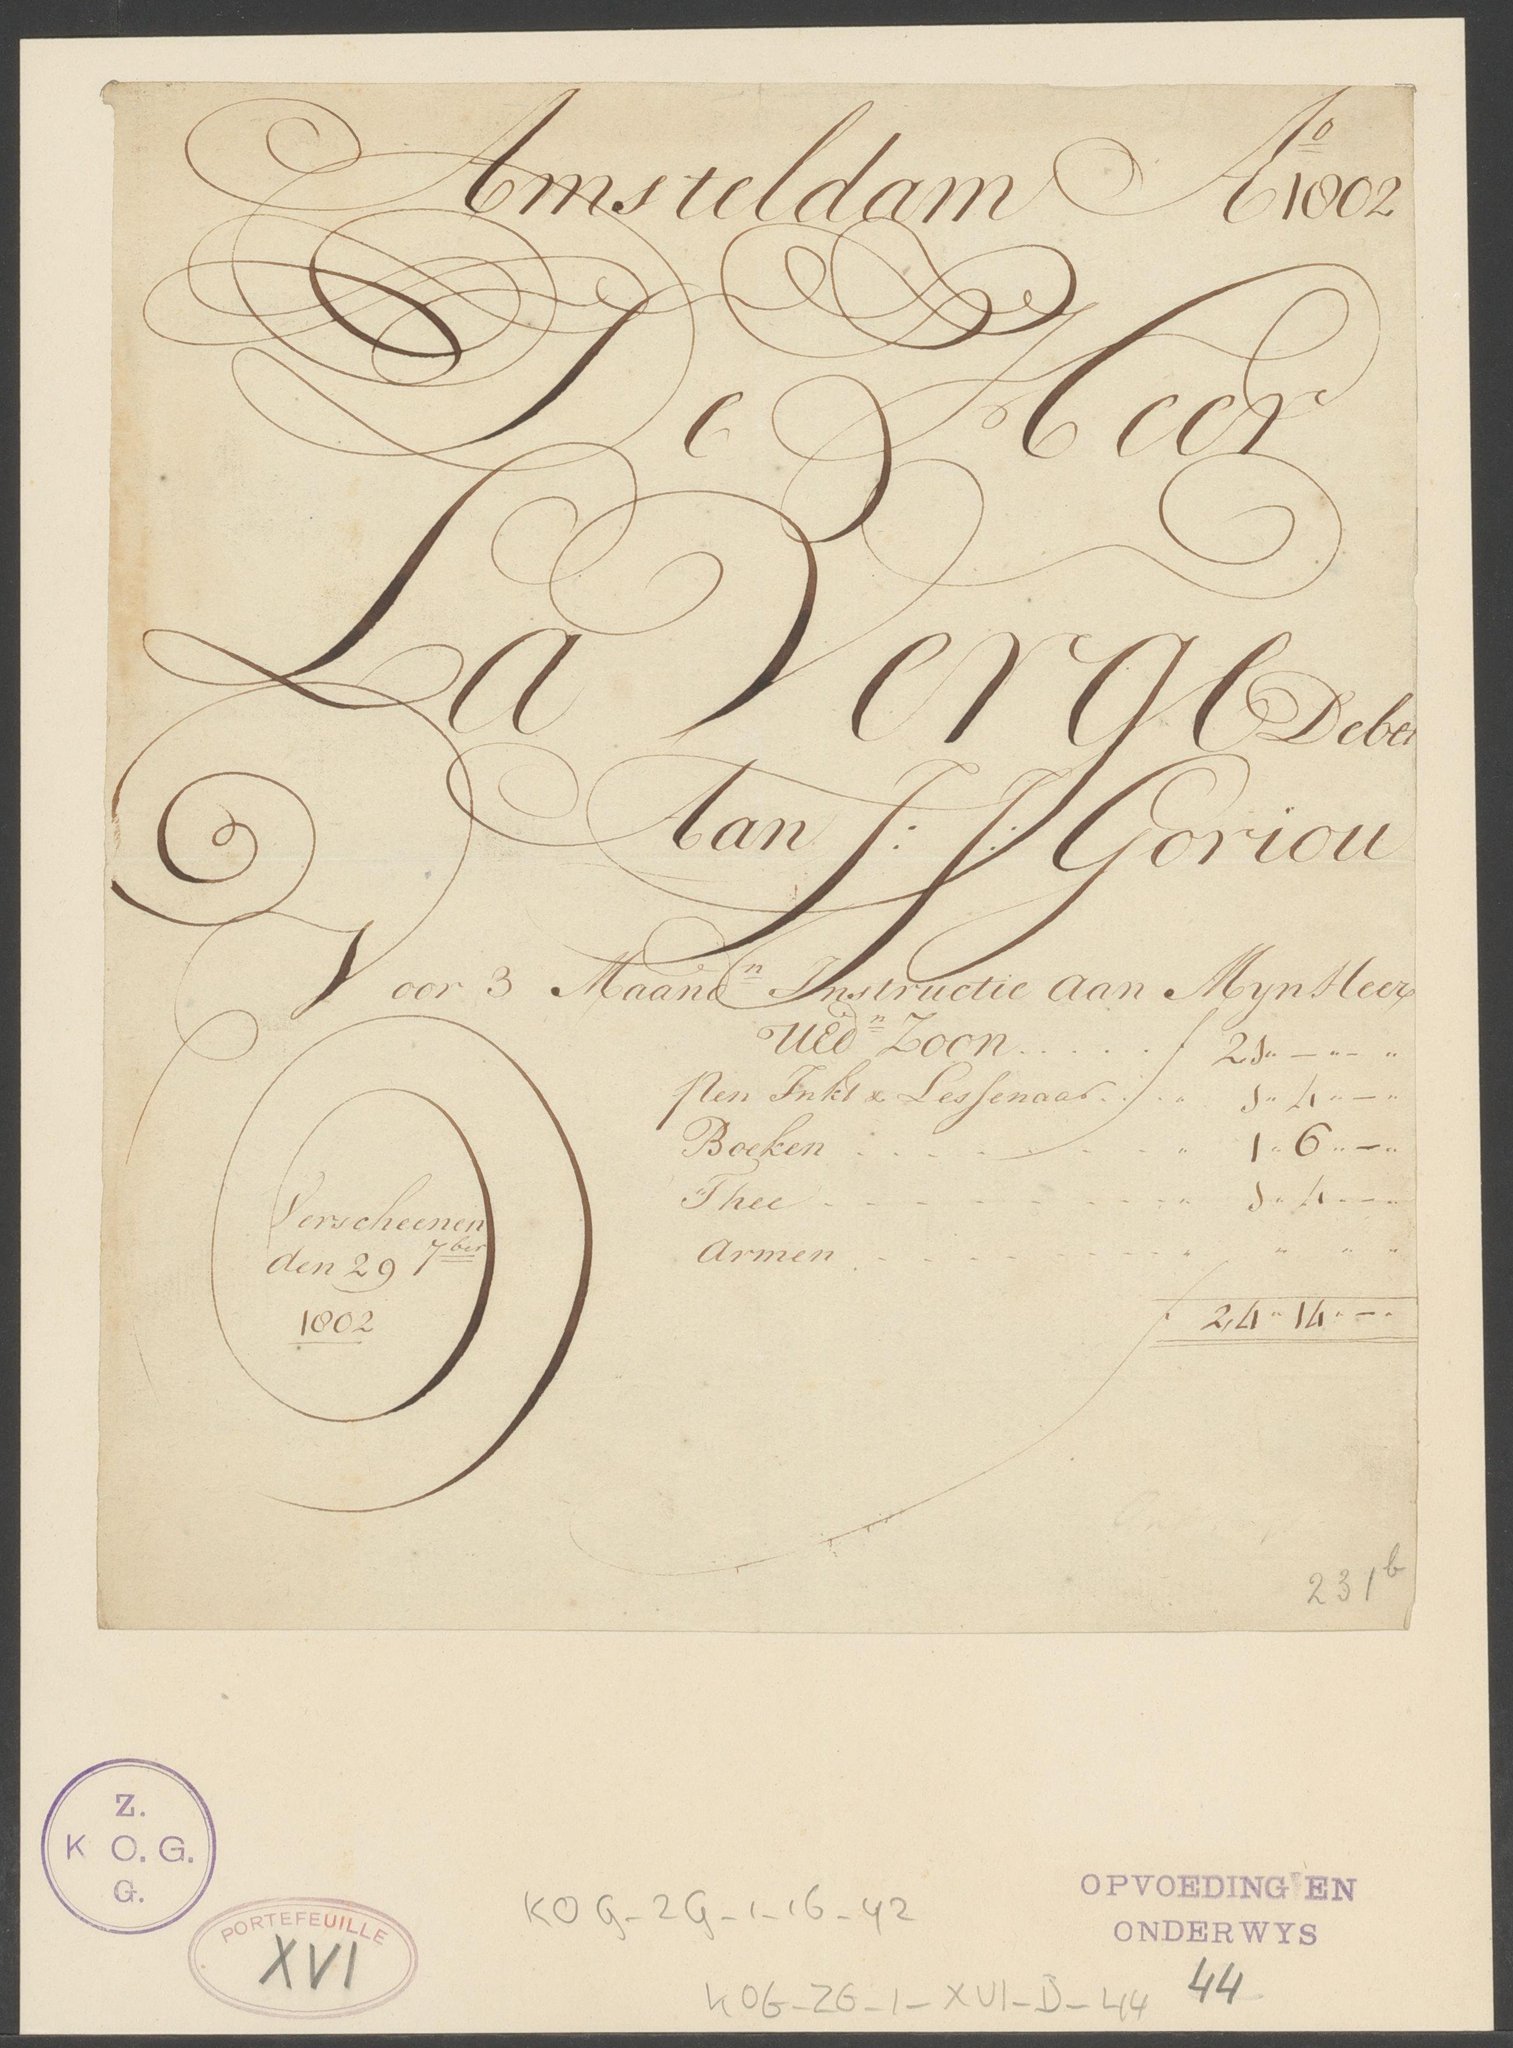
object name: manuscript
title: Rekening voor 3 maanden les door de heer La Verge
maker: la verge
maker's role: leraar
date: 1802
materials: ink, paper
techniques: pen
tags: education, science and learning, calligraphy, amsterdam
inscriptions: stamp, stamp, collector's mark: Lugt 1641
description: Rekening voor 3 maanden les door de heer La Verge aan de zoon van J.J. Goriou. De lessen, het gebruik van de pen, inkt en lessenaar, boeken en thee worden in rekening gebracht. Onderwerpsrubrieken binnen de Atlas Zeden en Gewoonten: Onderwijs en Wetenschappen, Opvoeding en Onderwijs, Pennekunst der schoolmeesters.